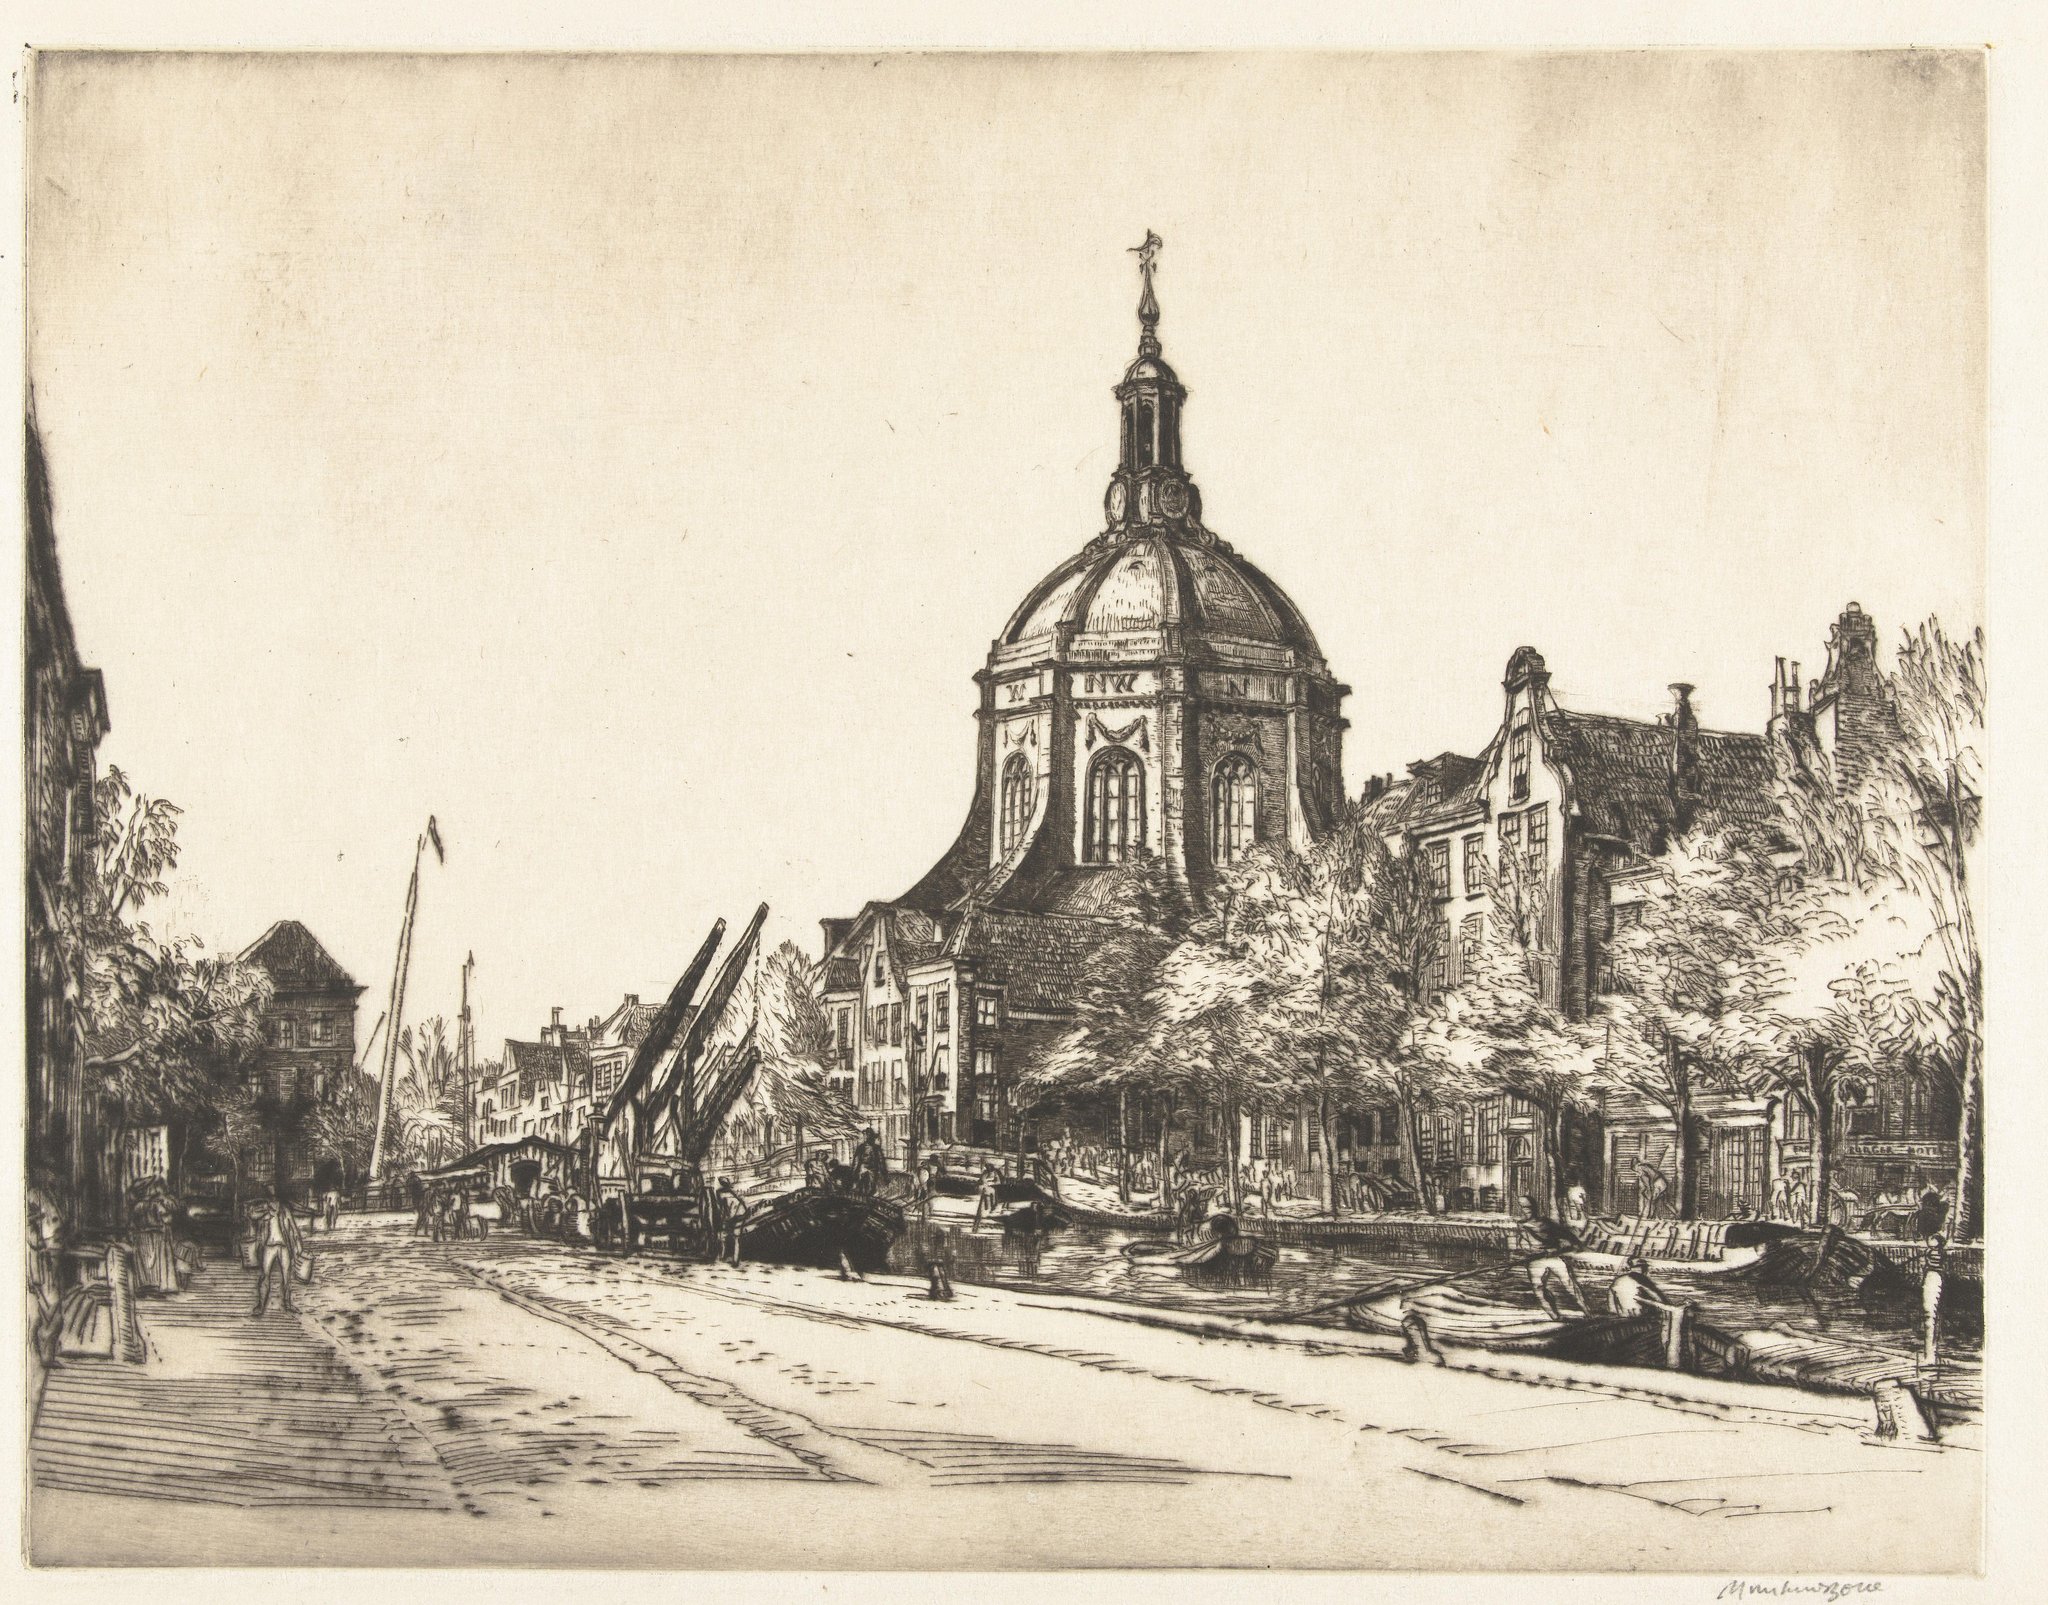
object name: print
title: Marekerk te Leiden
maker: muirhead bone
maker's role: artist, print maker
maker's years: 1876-1953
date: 1913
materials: paper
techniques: drypoint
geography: england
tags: church (exterior), canals, waters (in city), leiden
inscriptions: collector's mark: Lugt 2228, collector's mark: Lugt 2760, signature: ‘Muirhead Bone’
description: Gezicht op de Marekerk te Leiden, vanaf de overzijde van de gracht. Op de gracht aan aantal boten.